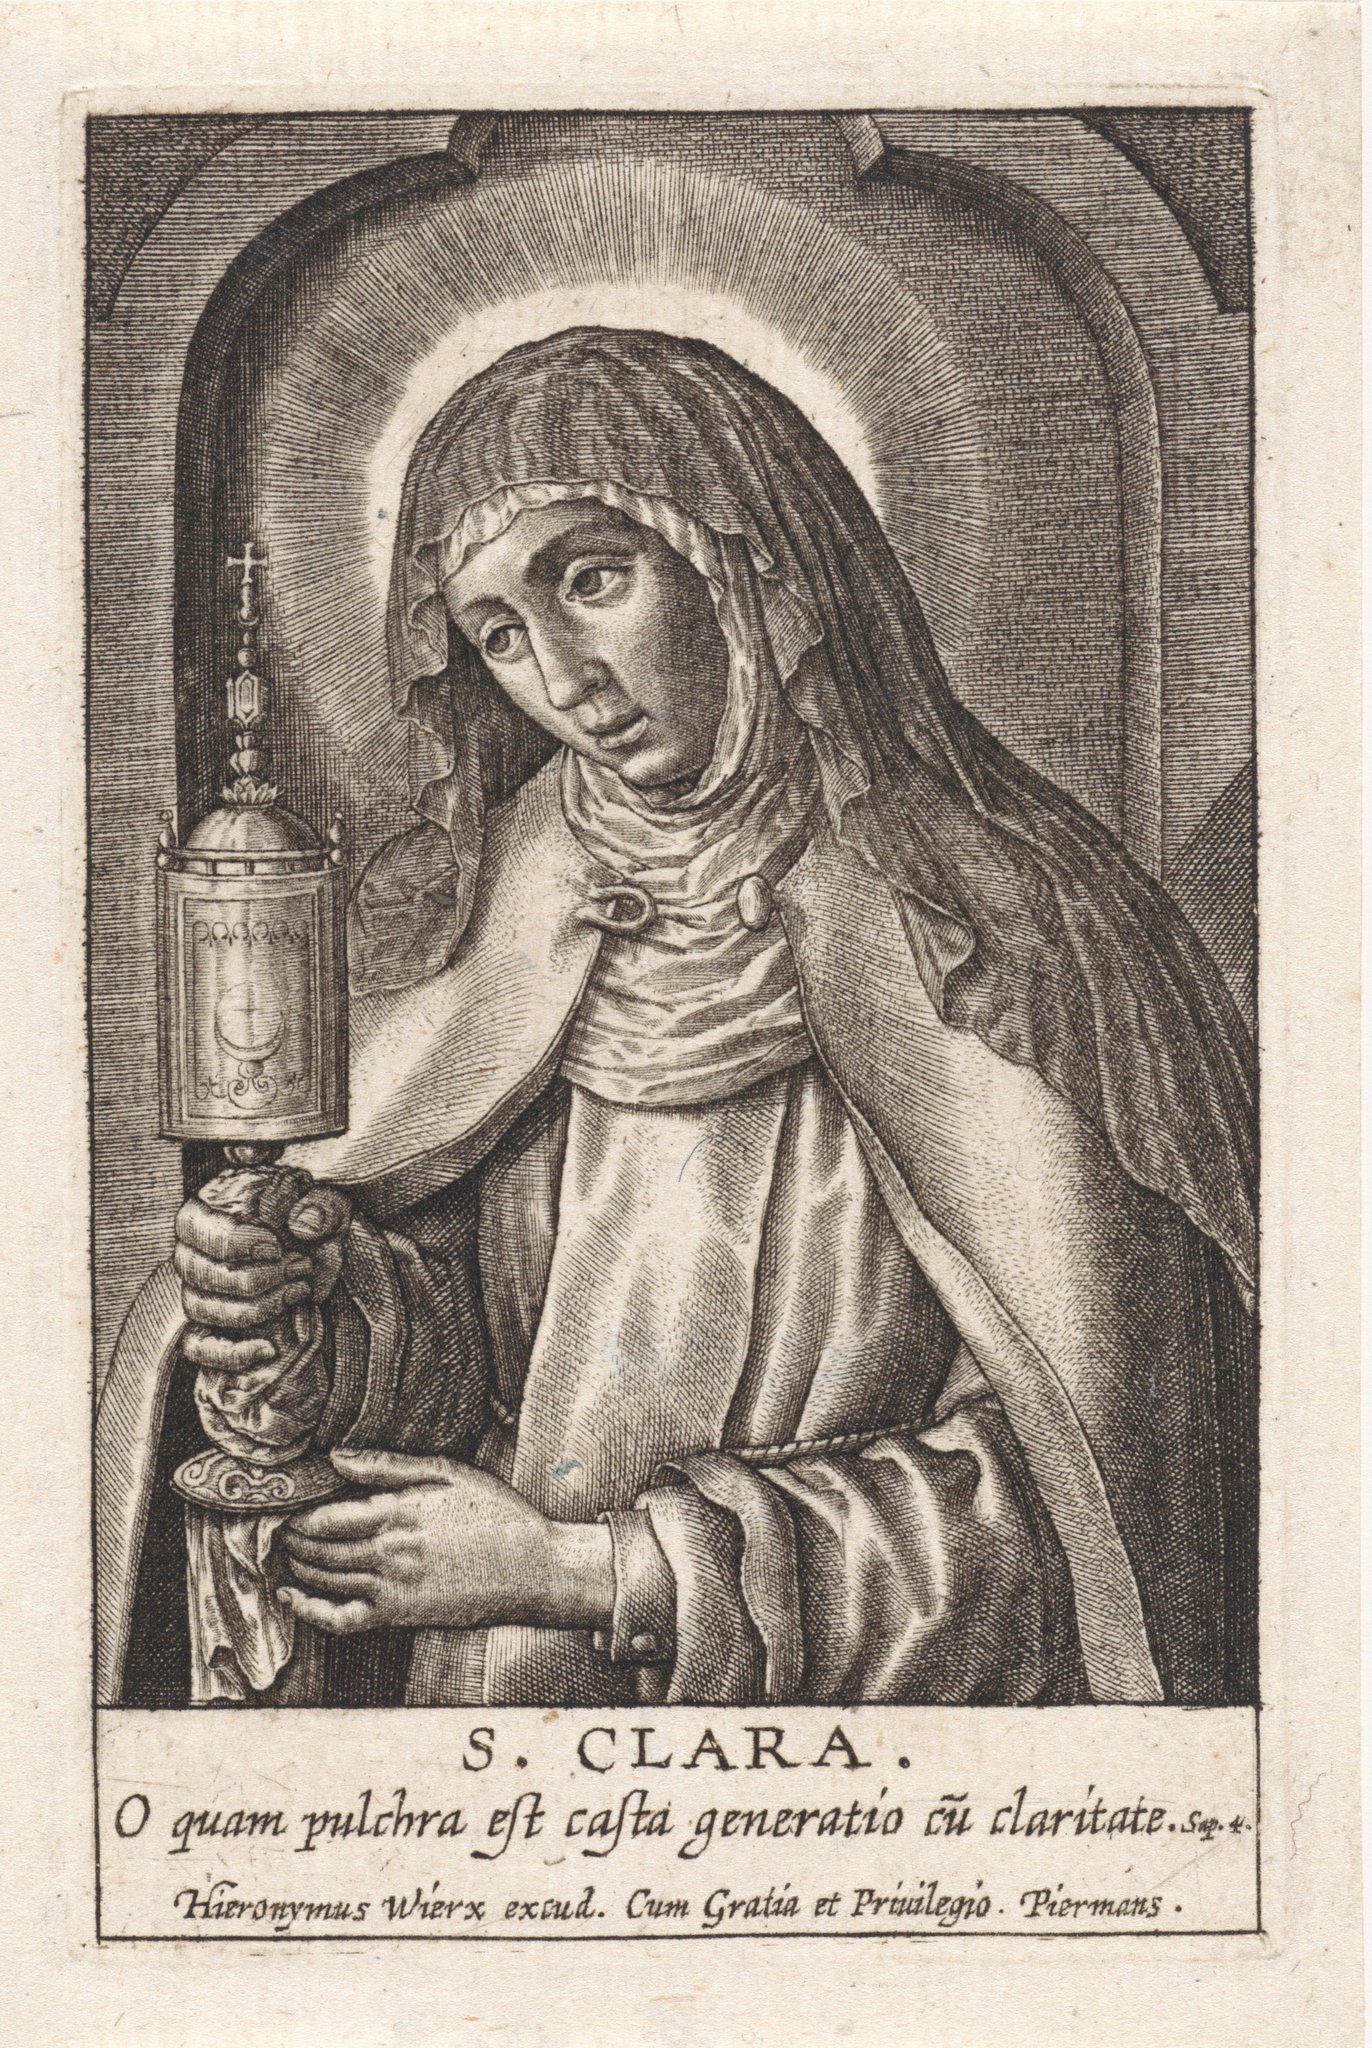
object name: print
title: H. Clara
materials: paper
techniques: engraving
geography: antwerp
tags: the virgin and foundress of the order of minoresses (or poor clares), clare of assisi; possible attributes: book, cross, flaming horn, lily, monstrance, palm-branch, pastoral staff, rosary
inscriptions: collector's mark: Lugt 2228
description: De heilige Clara, in het habijt van haar orde, met een geknoopte monniksgordel en een sluier. Ze houdt een monstrans in de hand, een verwijzing naar haar verdrijving van de Saracenen. In de marge een onderschrift in het Latijn.